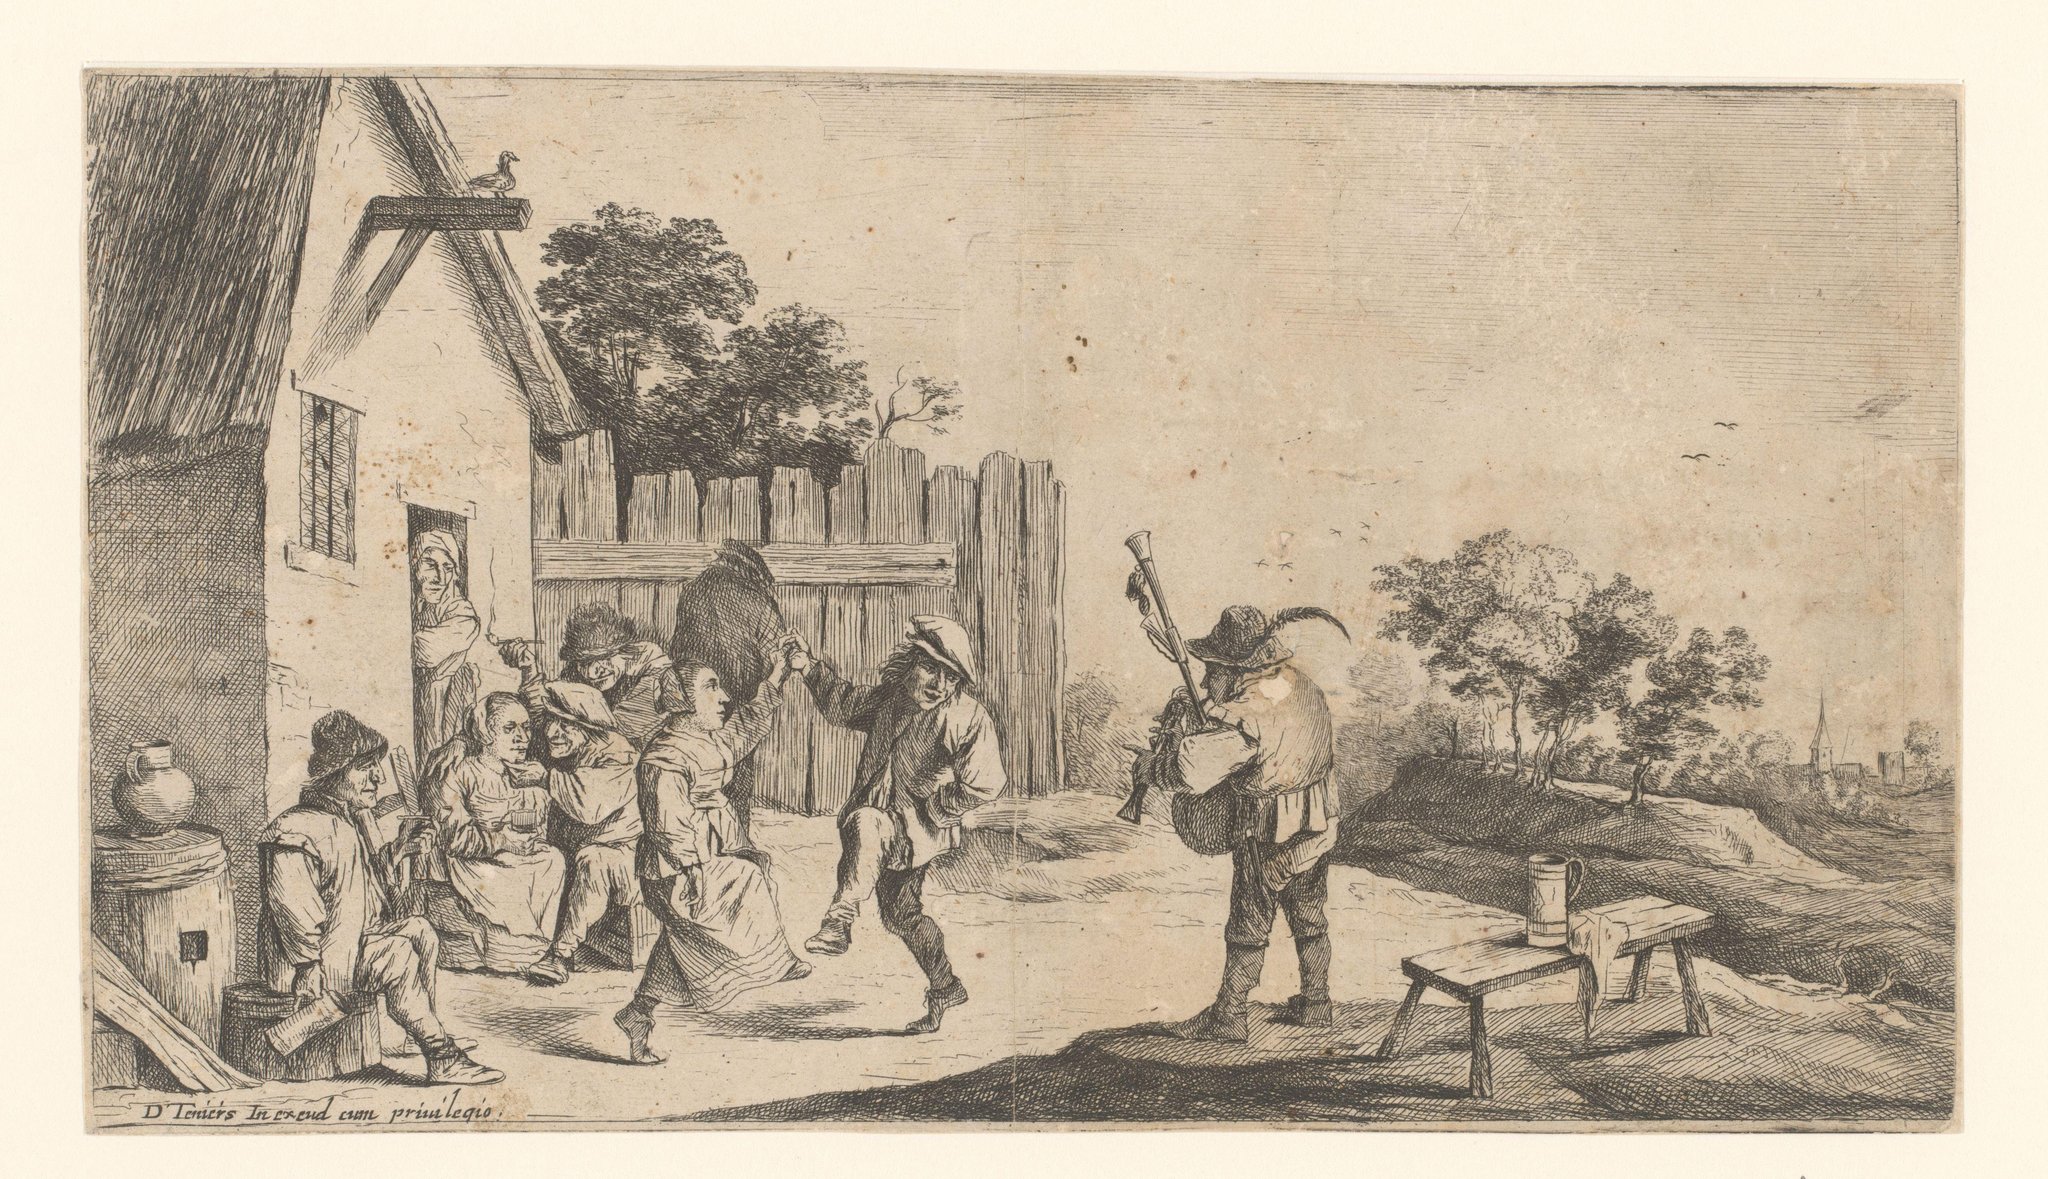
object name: print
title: Dans voor de herberg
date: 1626-1690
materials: paper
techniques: engraving, etching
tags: one pair dancing; man and woman dancing as a couple, farmers, bagpipe, musette - cc - out of doors, hotel, hostelry, inn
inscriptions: collector's mark: Lugt 240, collector's mark: Lugt 2228, inscription: ‘7 - Servetten van damast (...)/ water dwiellen’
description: Een paar danst voor een herberg op de muziek van een doedelzakspeler. Voor de herberg zitten drinkende boeren.